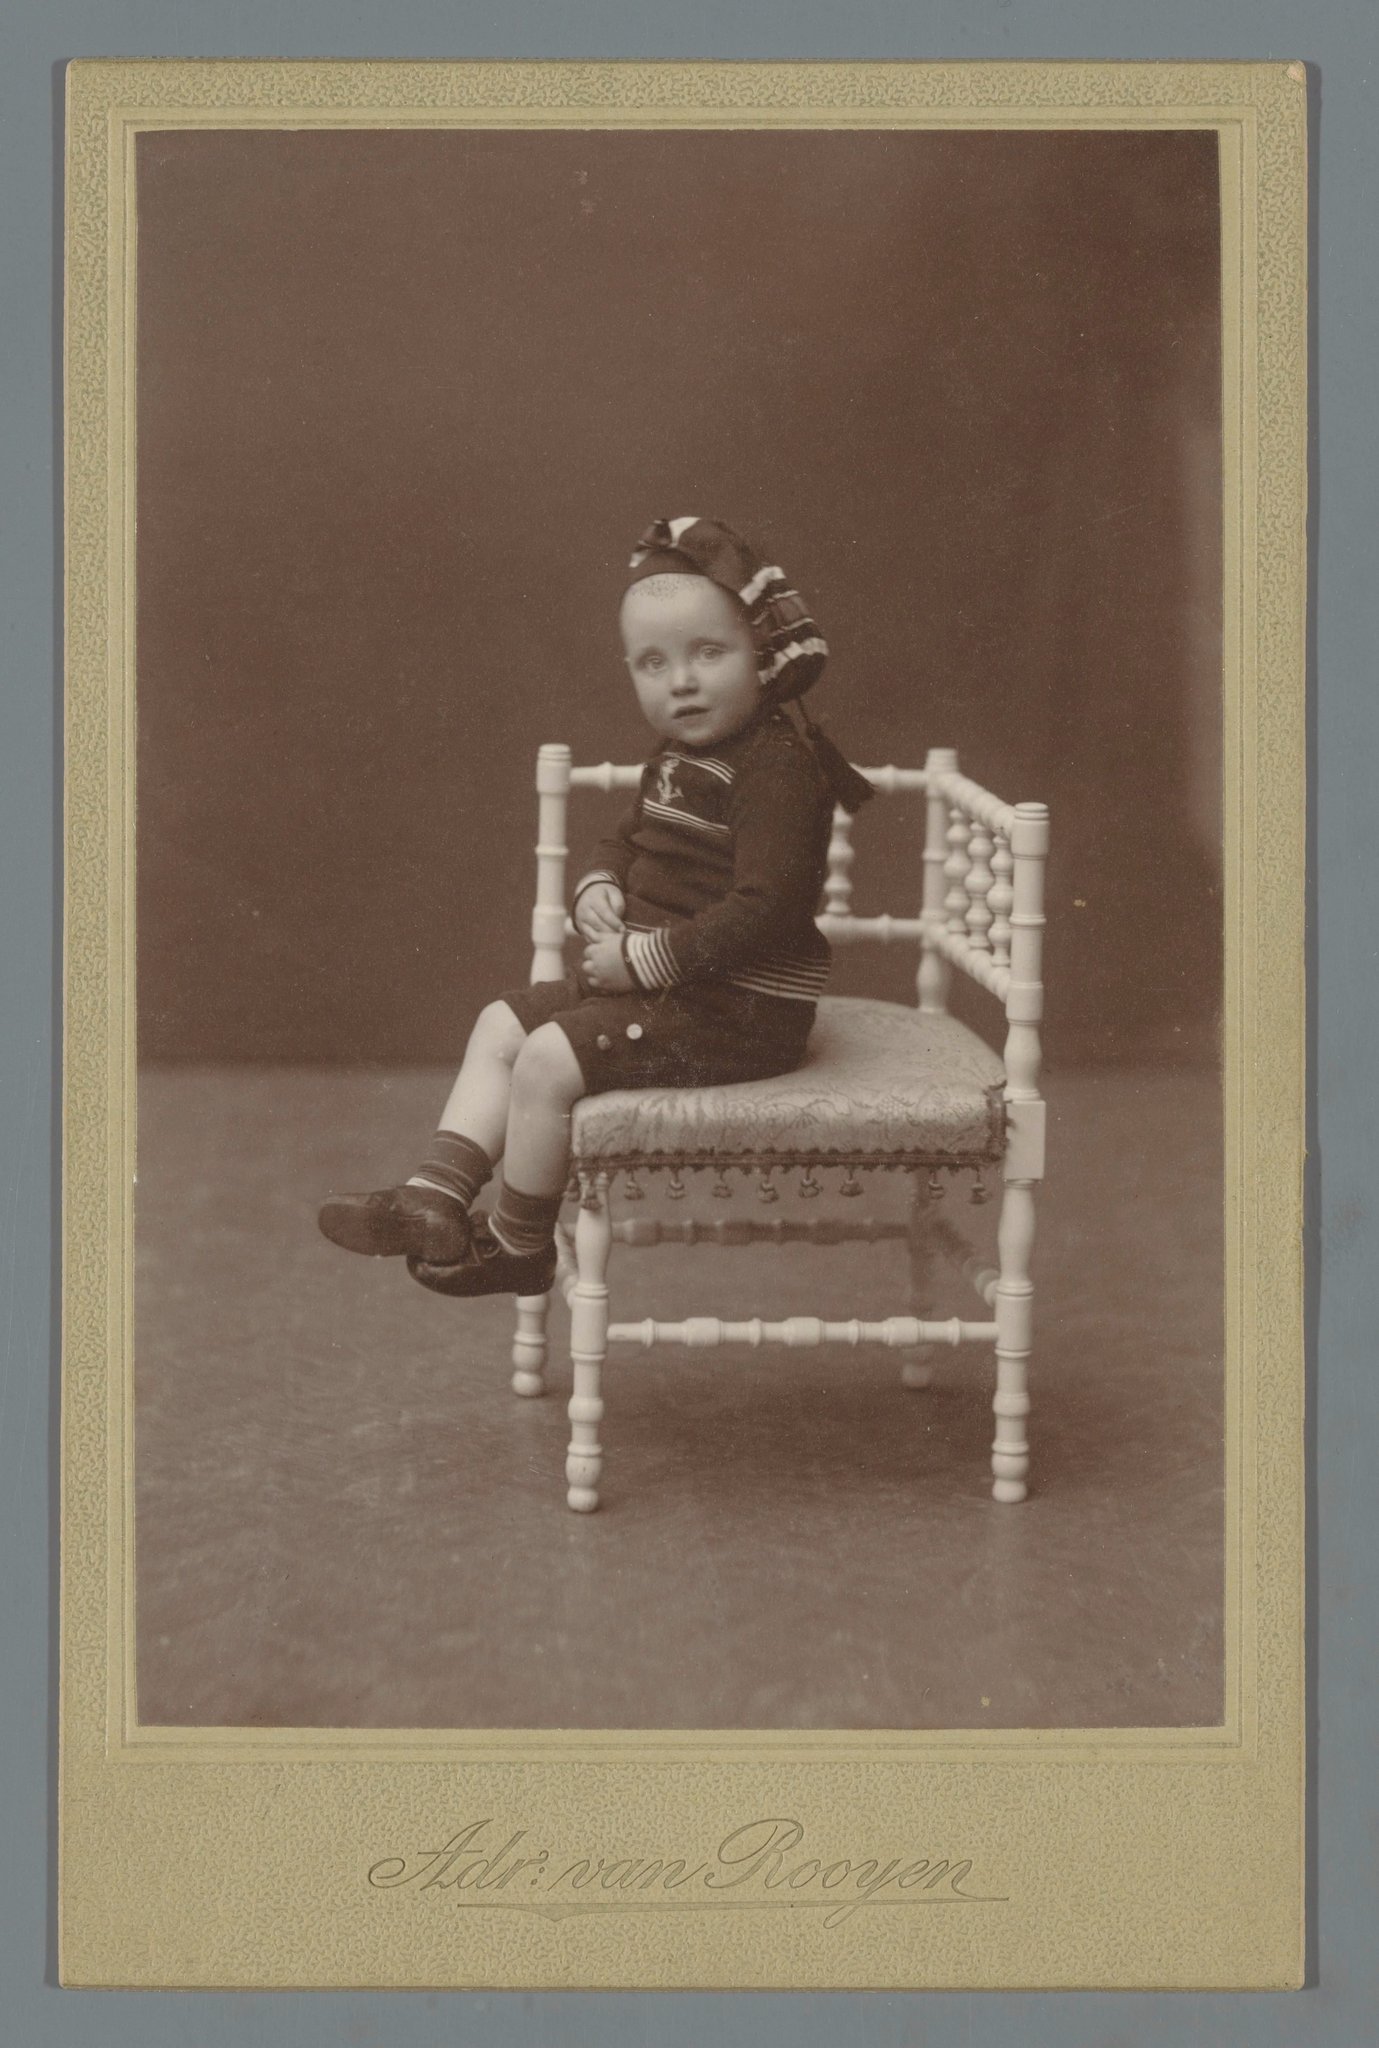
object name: photograph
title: Portret van een kleine jongen met gebreide muts en trui op een stoel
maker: adriaan van rooyen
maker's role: fotograaf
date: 1900-1920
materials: cardboard, photographic support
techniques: gelatin silver print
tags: head-gear: cap, child (at home)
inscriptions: : ‘Speciale Inrichting voor het maken van Vergrootingen en Reproductiën in nieuwe en duurzame uitvoering. De Plaat blijft voor nabestelling bewaard.’, : ‘Alfen a/d Rijn’, monogram: ‘AR’